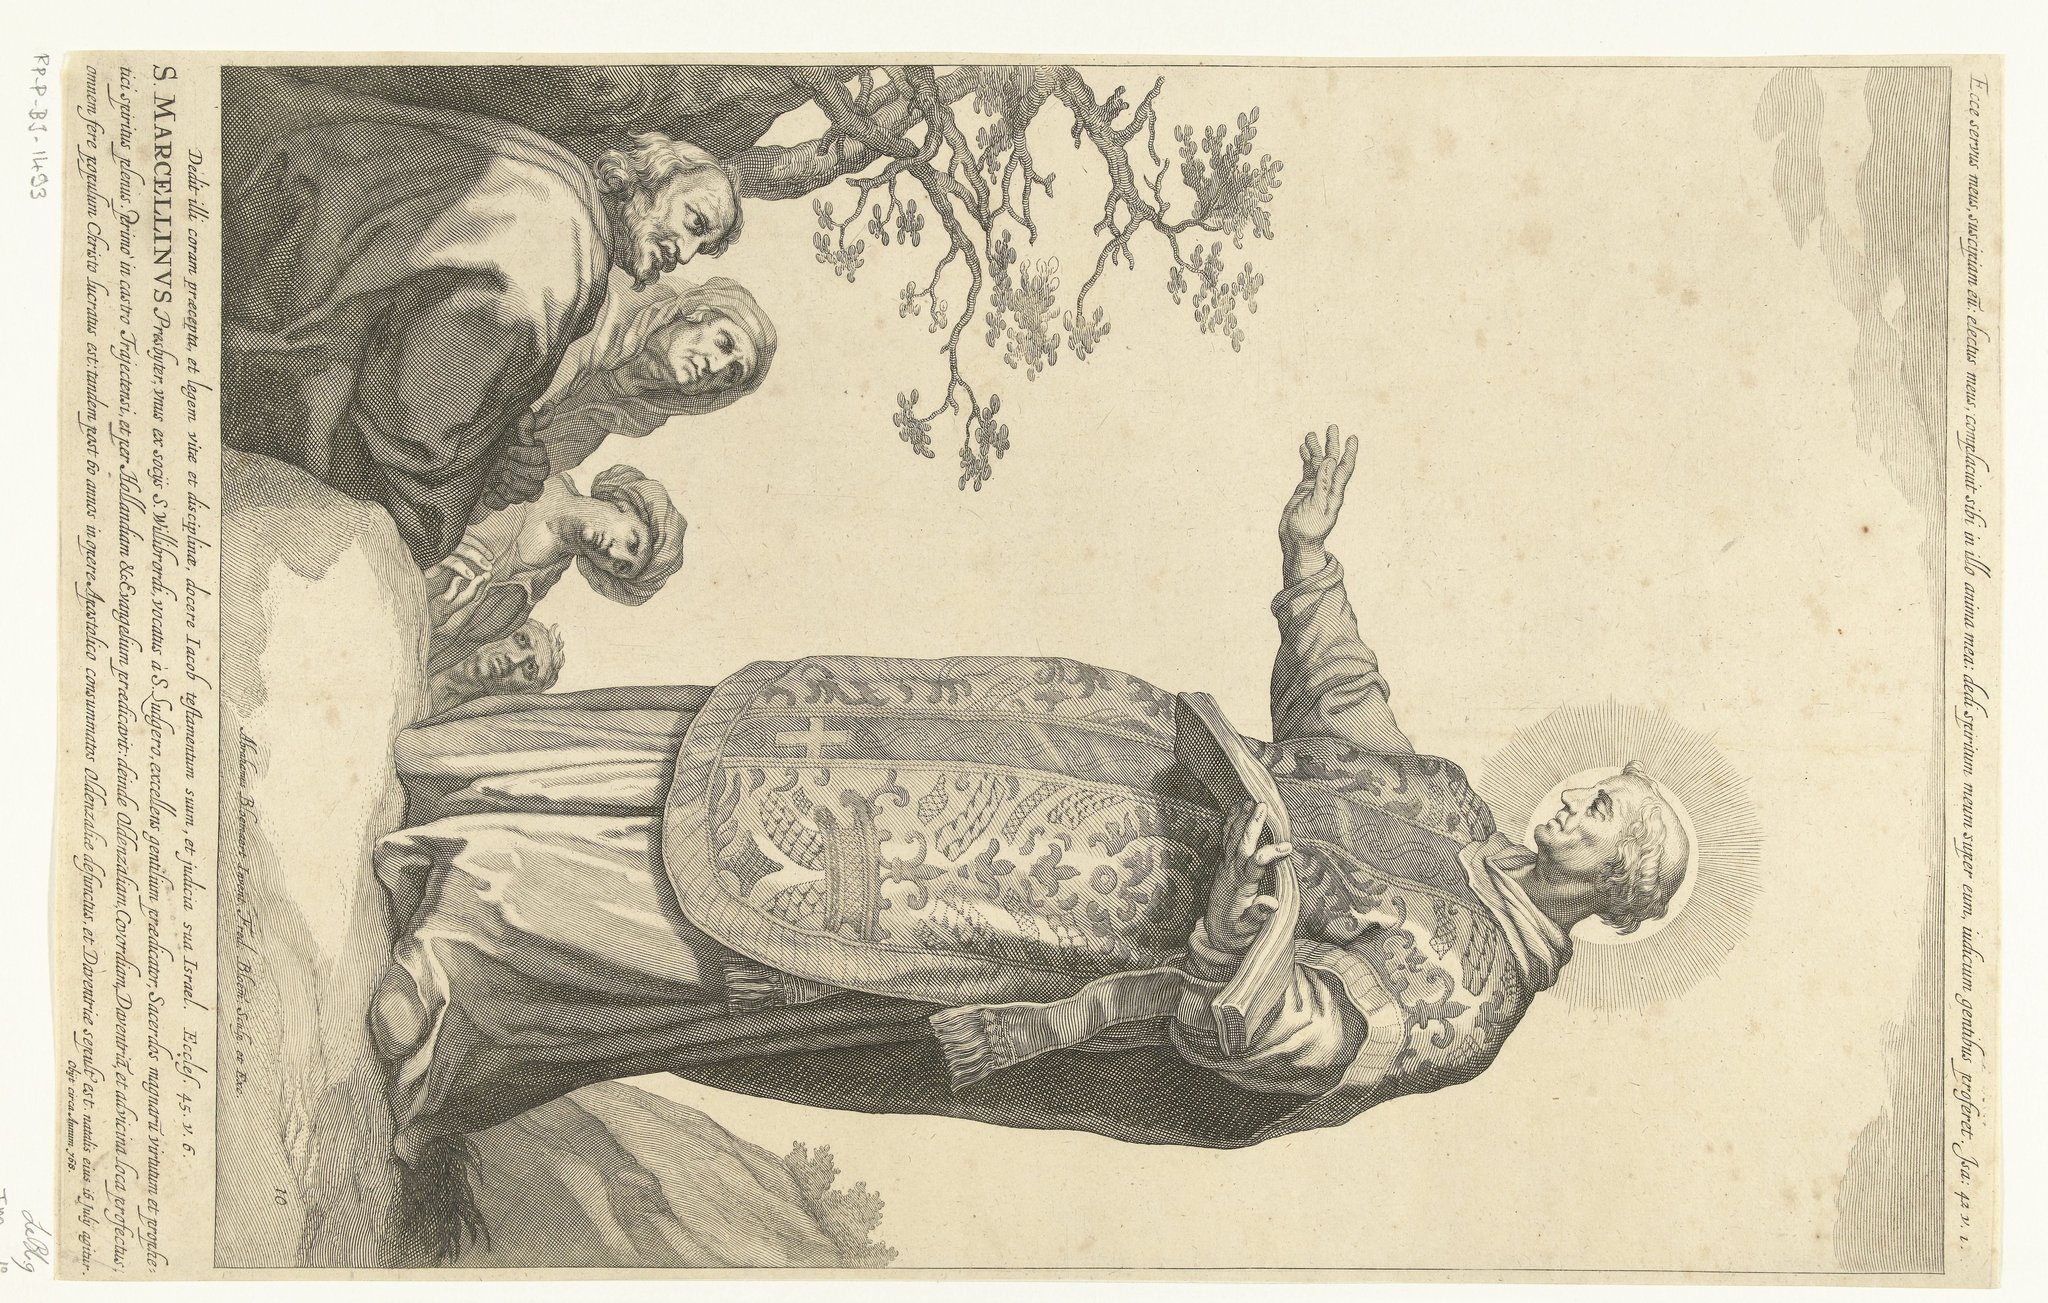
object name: print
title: Heilige Marcellinus van Deventer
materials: paper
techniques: engraving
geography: utrecht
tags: marcellinus van deventer, merovingische en karolingische tijd in nederland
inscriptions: collector's mark: Lugt 240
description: De heilige Marcellinus afgebeeld als een priester met tuniek, kazuifel, en armdoek. Hij gaat leken voor in het gebed. Met Latijns onderschrift. Prent uit een serie van twaalf prenten met prelaten en bisschoppen van Utrecht door Cornelis en Frederick Bloemaert.